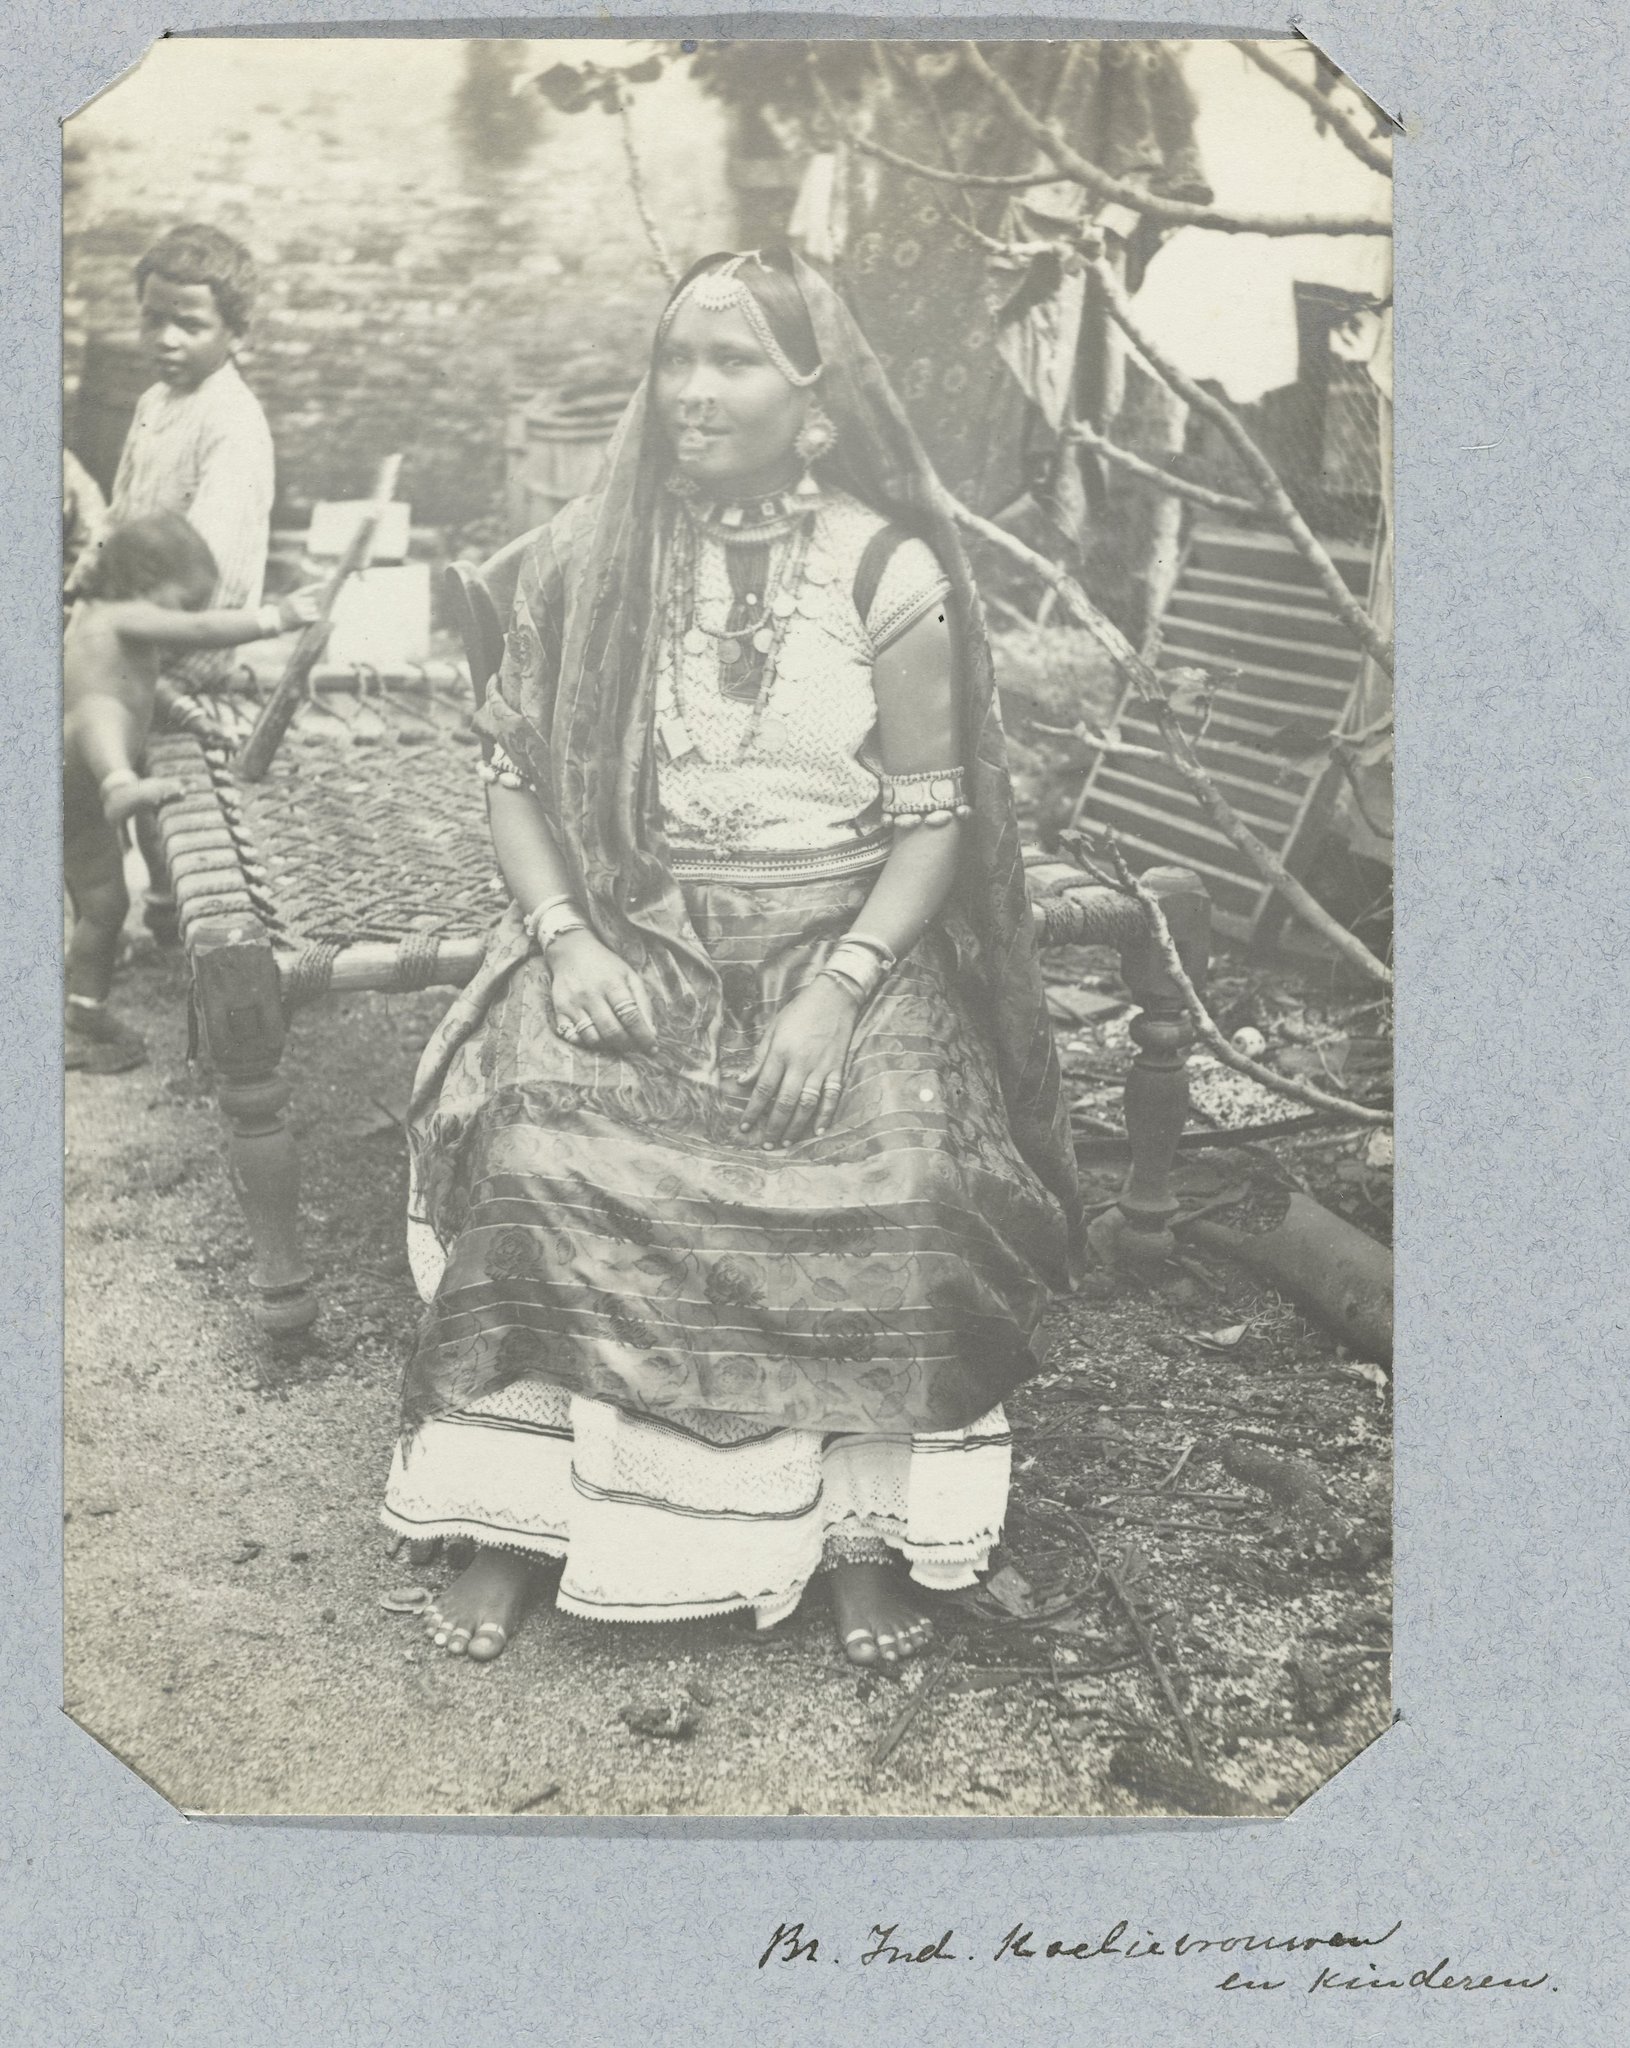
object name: photograph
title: Hindustani Women with Children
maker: théodore van lelyveld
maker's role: painter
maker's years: 1867-1954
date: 1895-1898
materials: photographic support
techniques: gelatin silver print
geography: suriname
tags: migrants, working class, labourers, anonymous historical person portrayed - bb - woman, suriname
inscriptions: inscription: ‘Br. Ind. Koelievrouwen en kinderen.’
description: Van Lelyveld takes these photographs for his article on the clothing of Hindustani women. Both women wear a mohar málá, a necklace made of coins. The children also wear jewellery. The jewels represent the women’s capital and afford insight into their position within the Hindustani community. In Suriname many women transcend the caste they originally had in India.